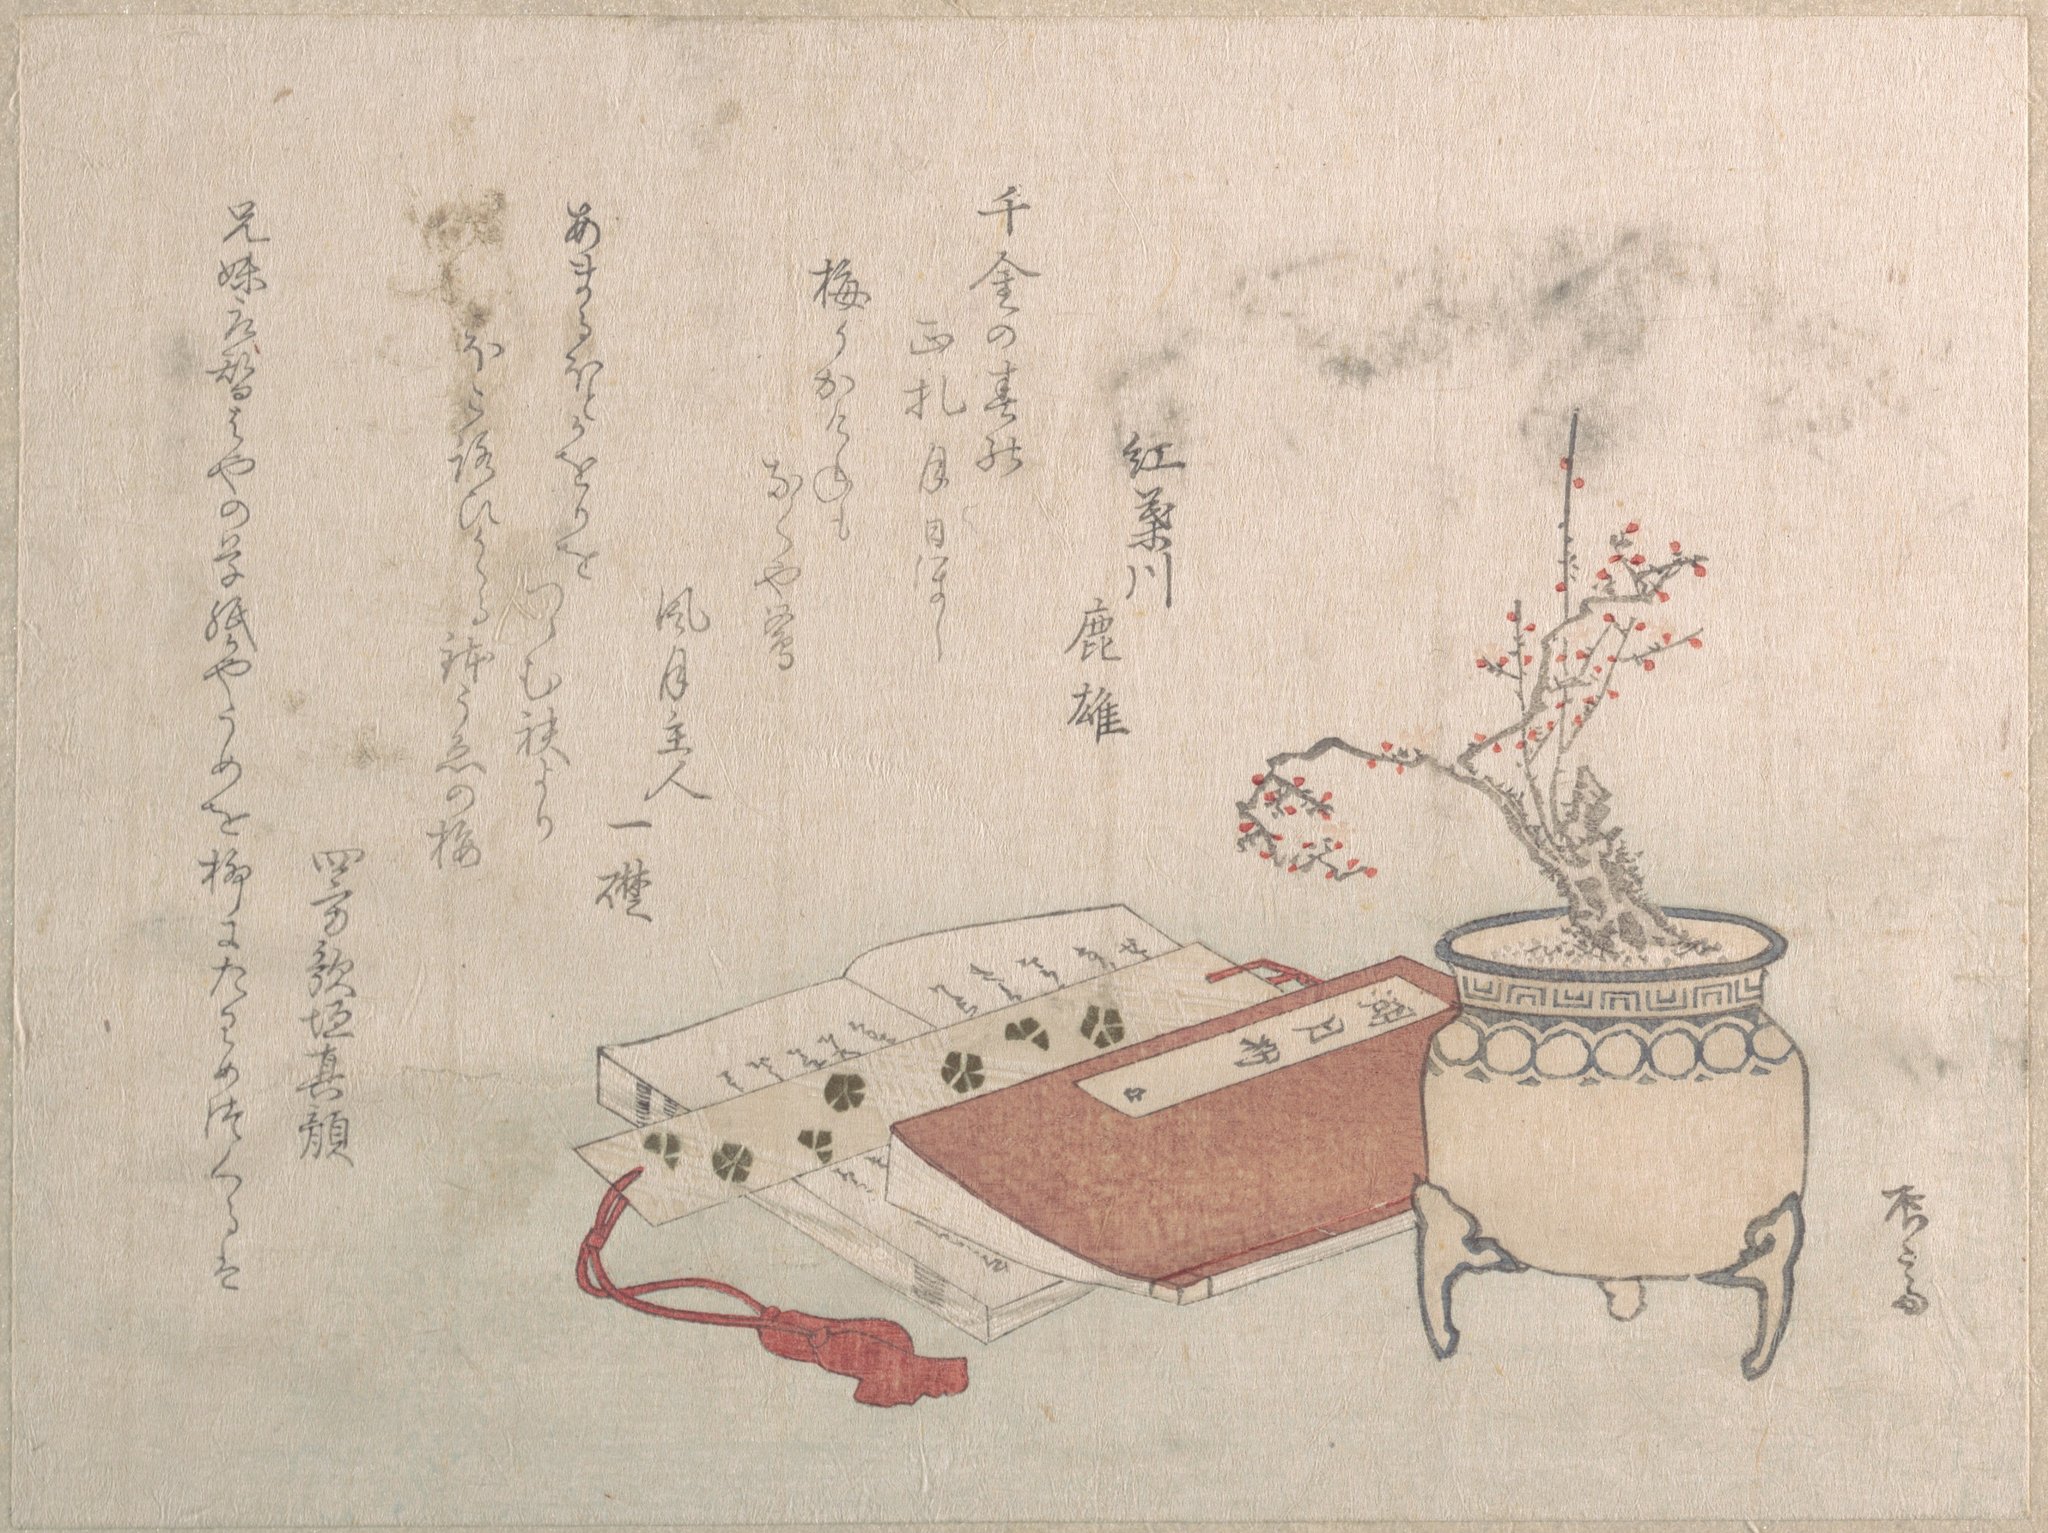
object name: woodblock print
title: Potted Plum Tree in Blossom and Books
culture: japanese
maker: ryūryūkyo shinsai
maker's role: artist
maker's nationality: japanese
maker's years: 1799-1823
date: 1801-1900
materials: ink, paper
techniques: surimono, woodblock print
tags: books,palms